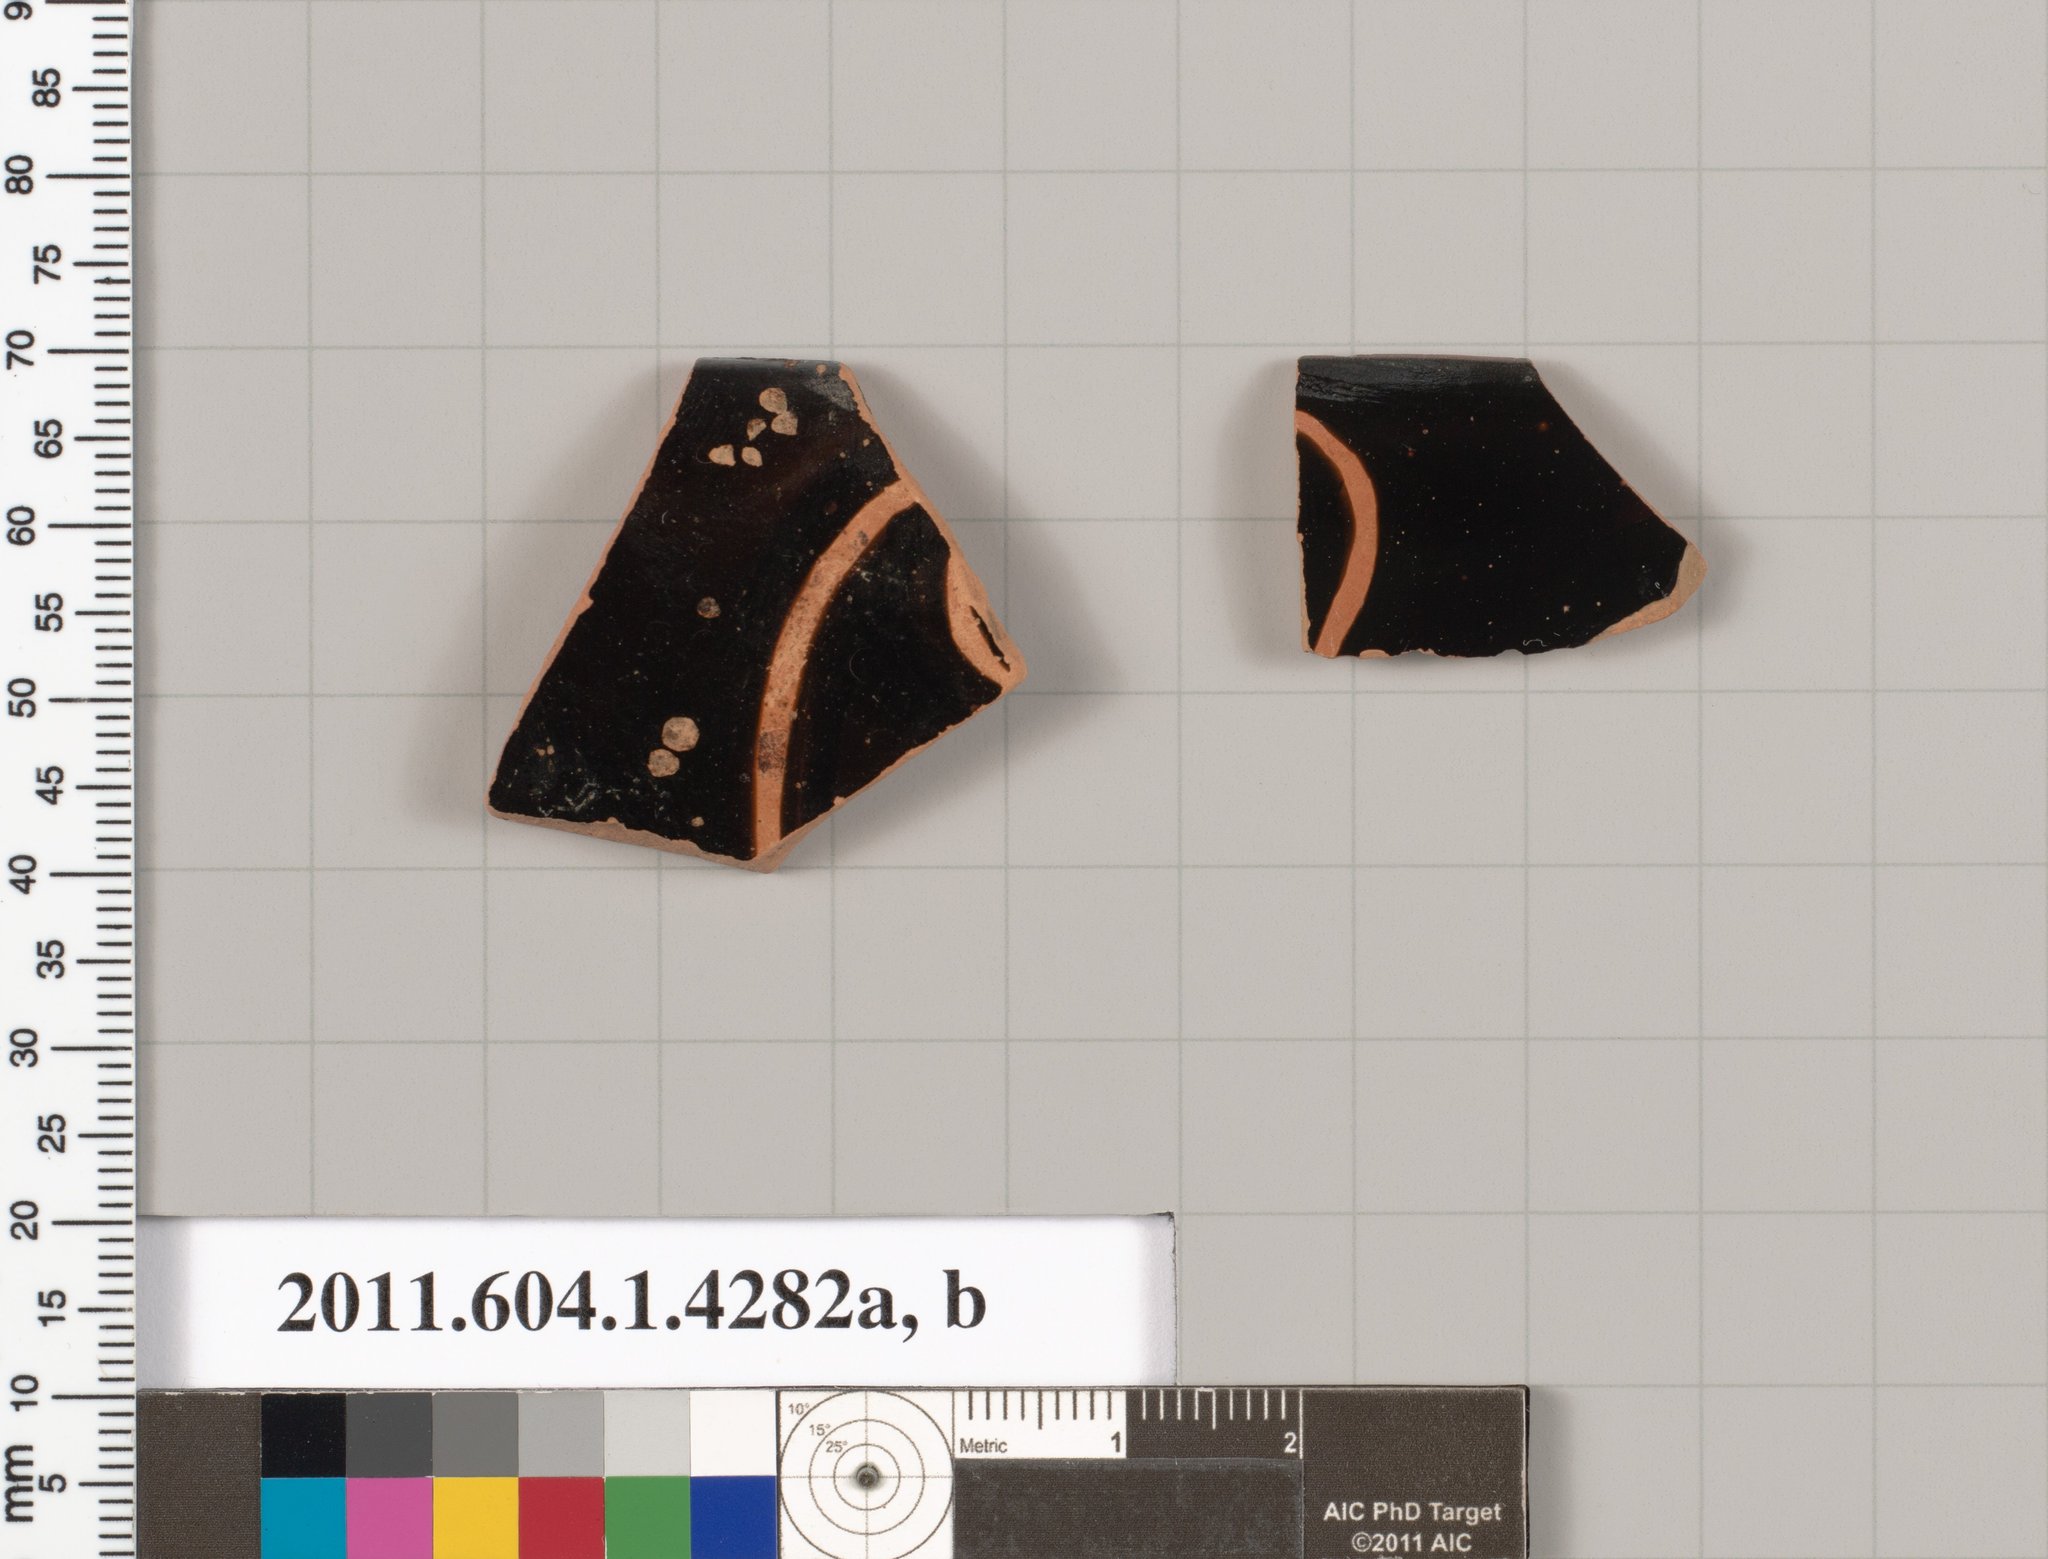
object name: kylix fragment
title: Terracotta rim fragments of kylikes (drinking cups)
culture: greek, attic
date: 500-451 BCE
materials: terracotta